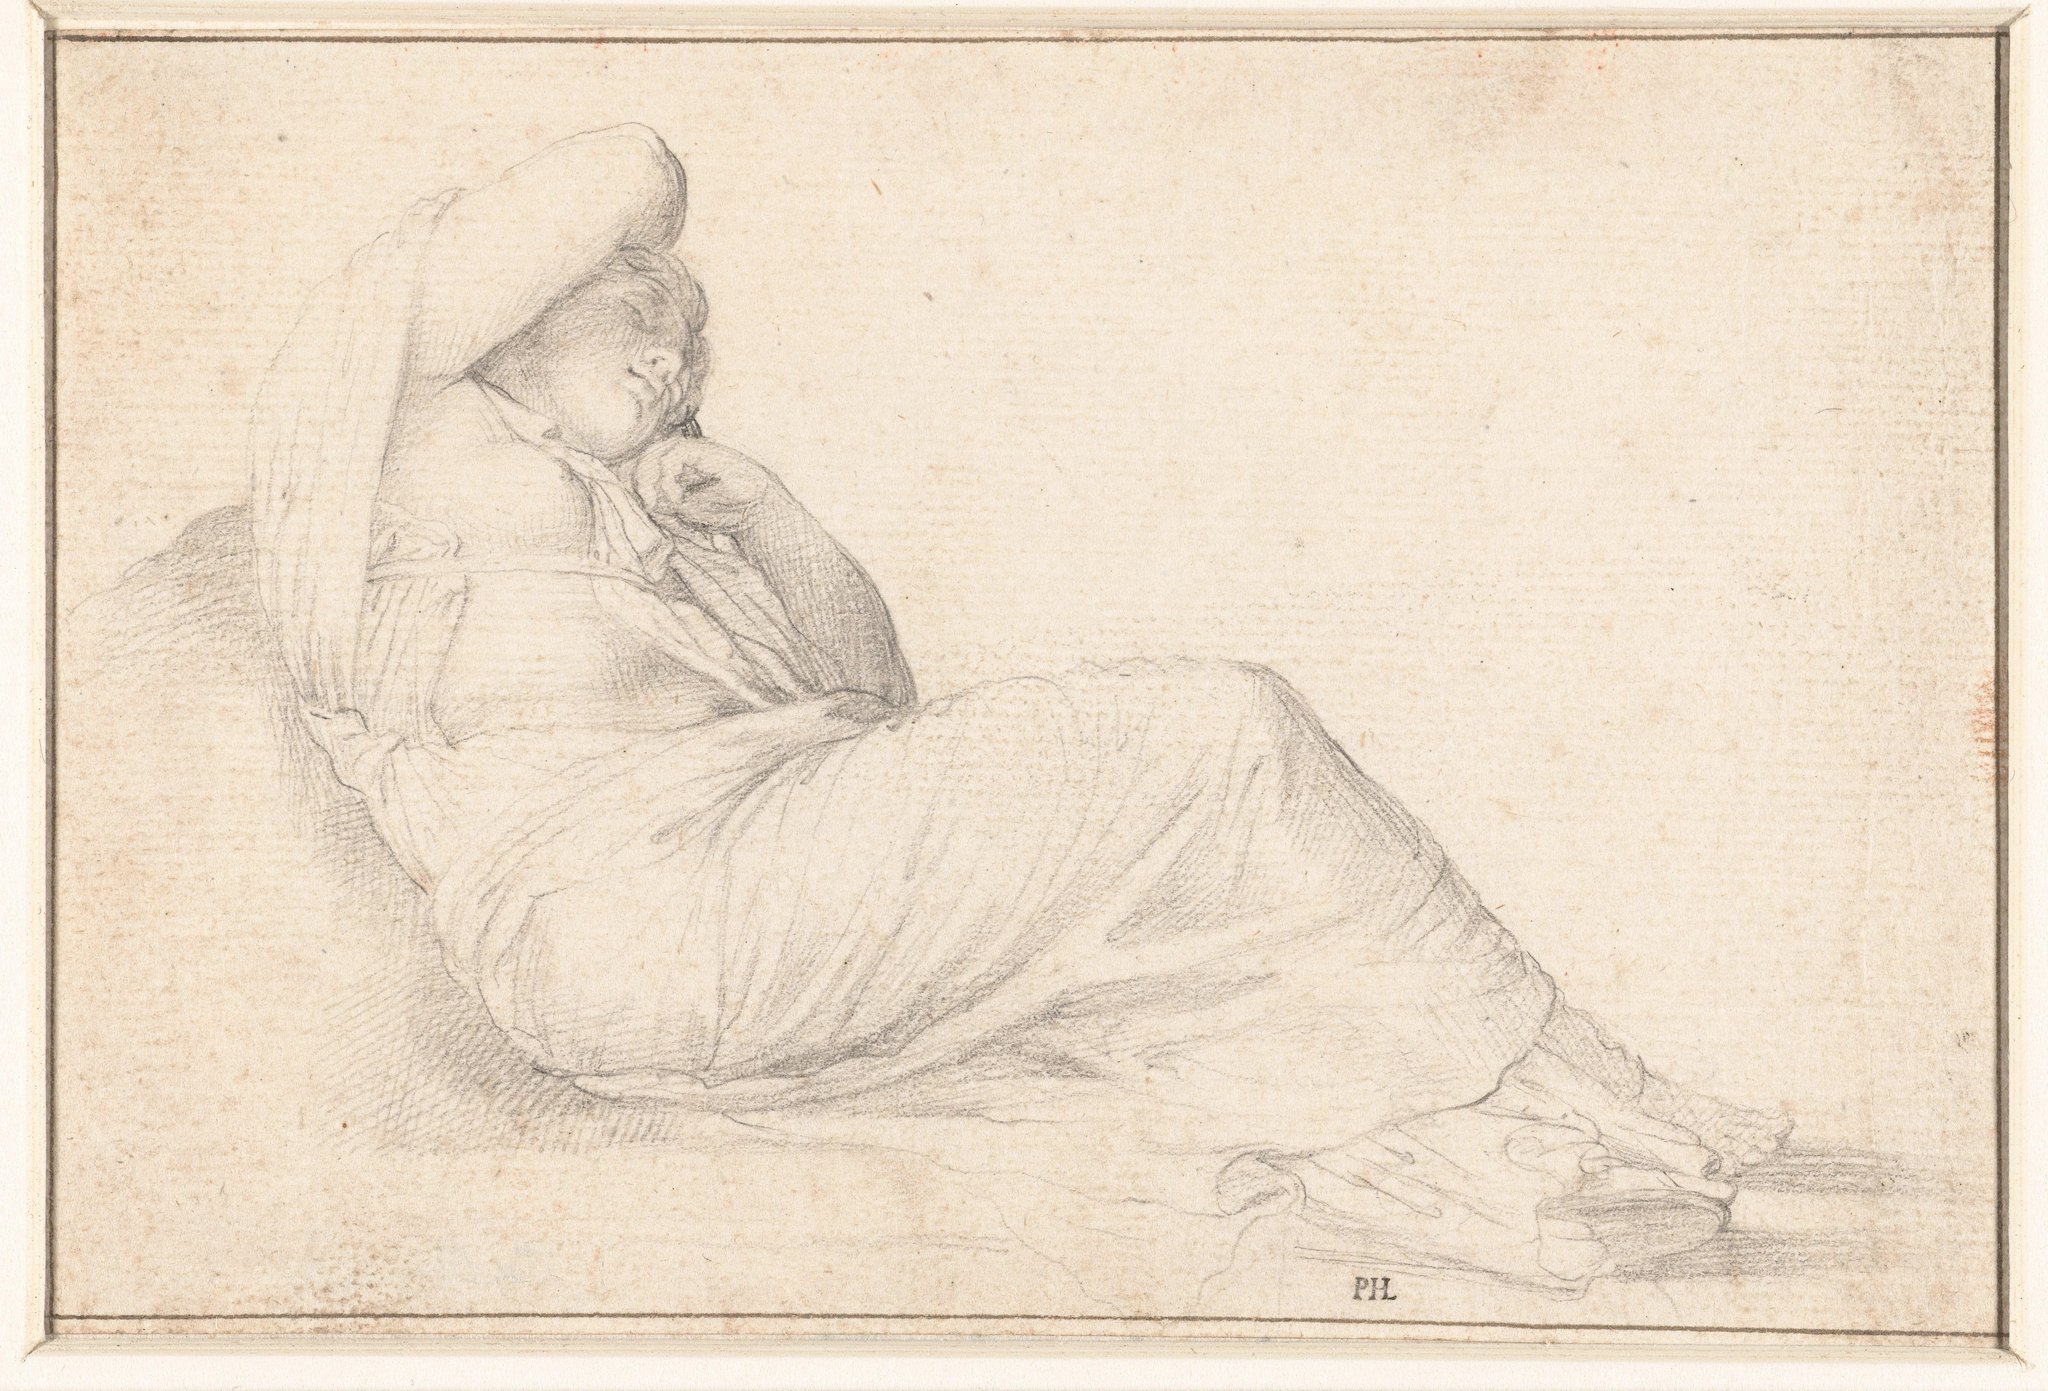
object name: drawing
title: Slapende vrouw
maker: francesco salviati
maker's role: draughtsman, painter, print maker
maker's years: 1510-1563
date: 1520-1563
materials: paper, pencil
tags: sleeping; unconsciousness